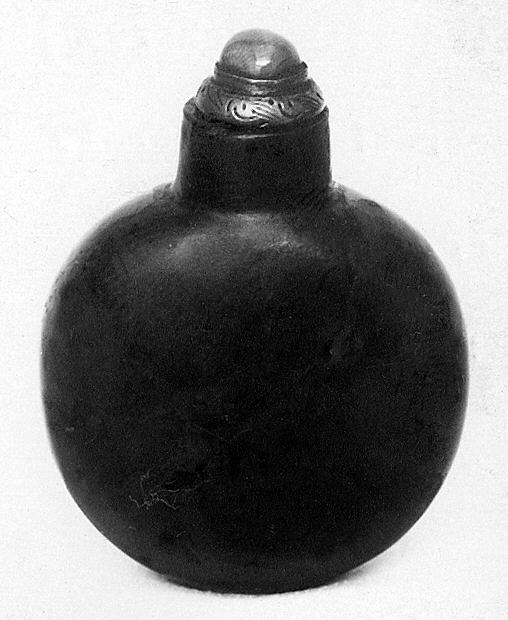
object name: snuff bottle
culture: chinese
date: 1867-1900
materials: jasper